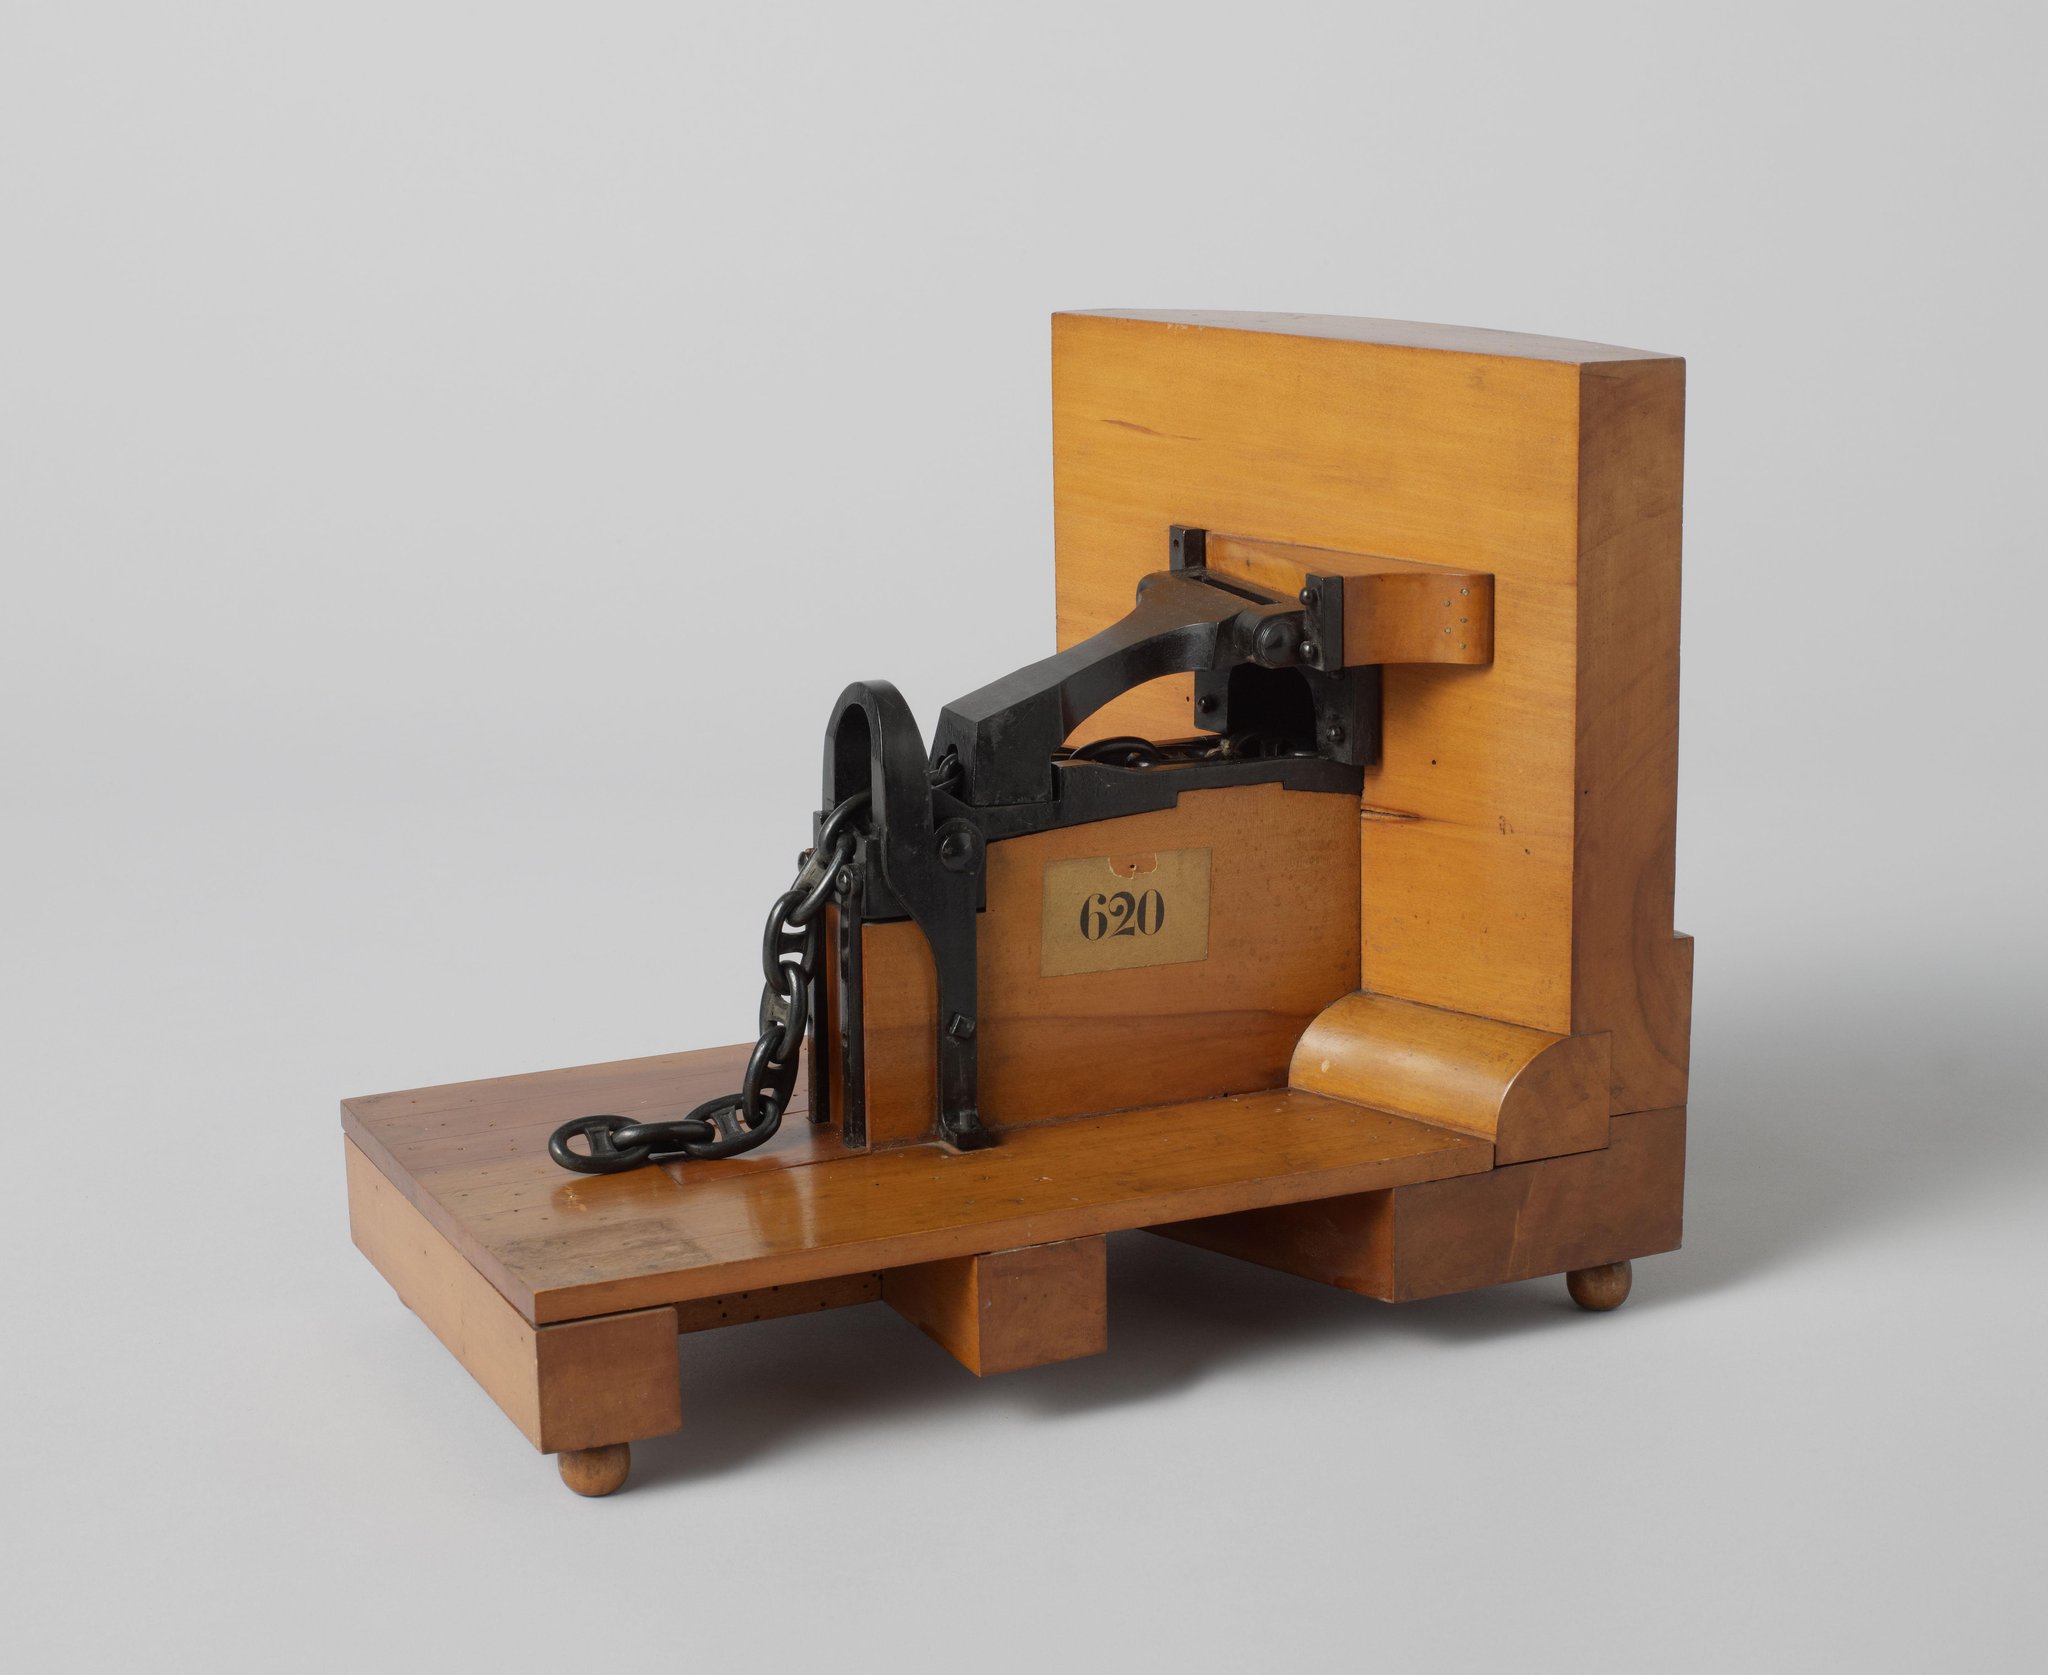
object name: demonstration model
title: Model of a Chain Stopper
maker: Anonymous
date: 1831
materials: iron, wood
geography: france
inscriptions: label, on the chock: ‘620’ former inventory label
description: Model van een kettingstopper tussen twee dekken, bestaande uit een glijbaan voor de ketting op een klos en doorlopend door het bakboord kluisgat, en een zware duivelsklauw hangend aan een klos aan de scheepswand. Een houten ketting met namaakgewicht is aan het model toegevoegd. Schaal 1:10 (schatting).